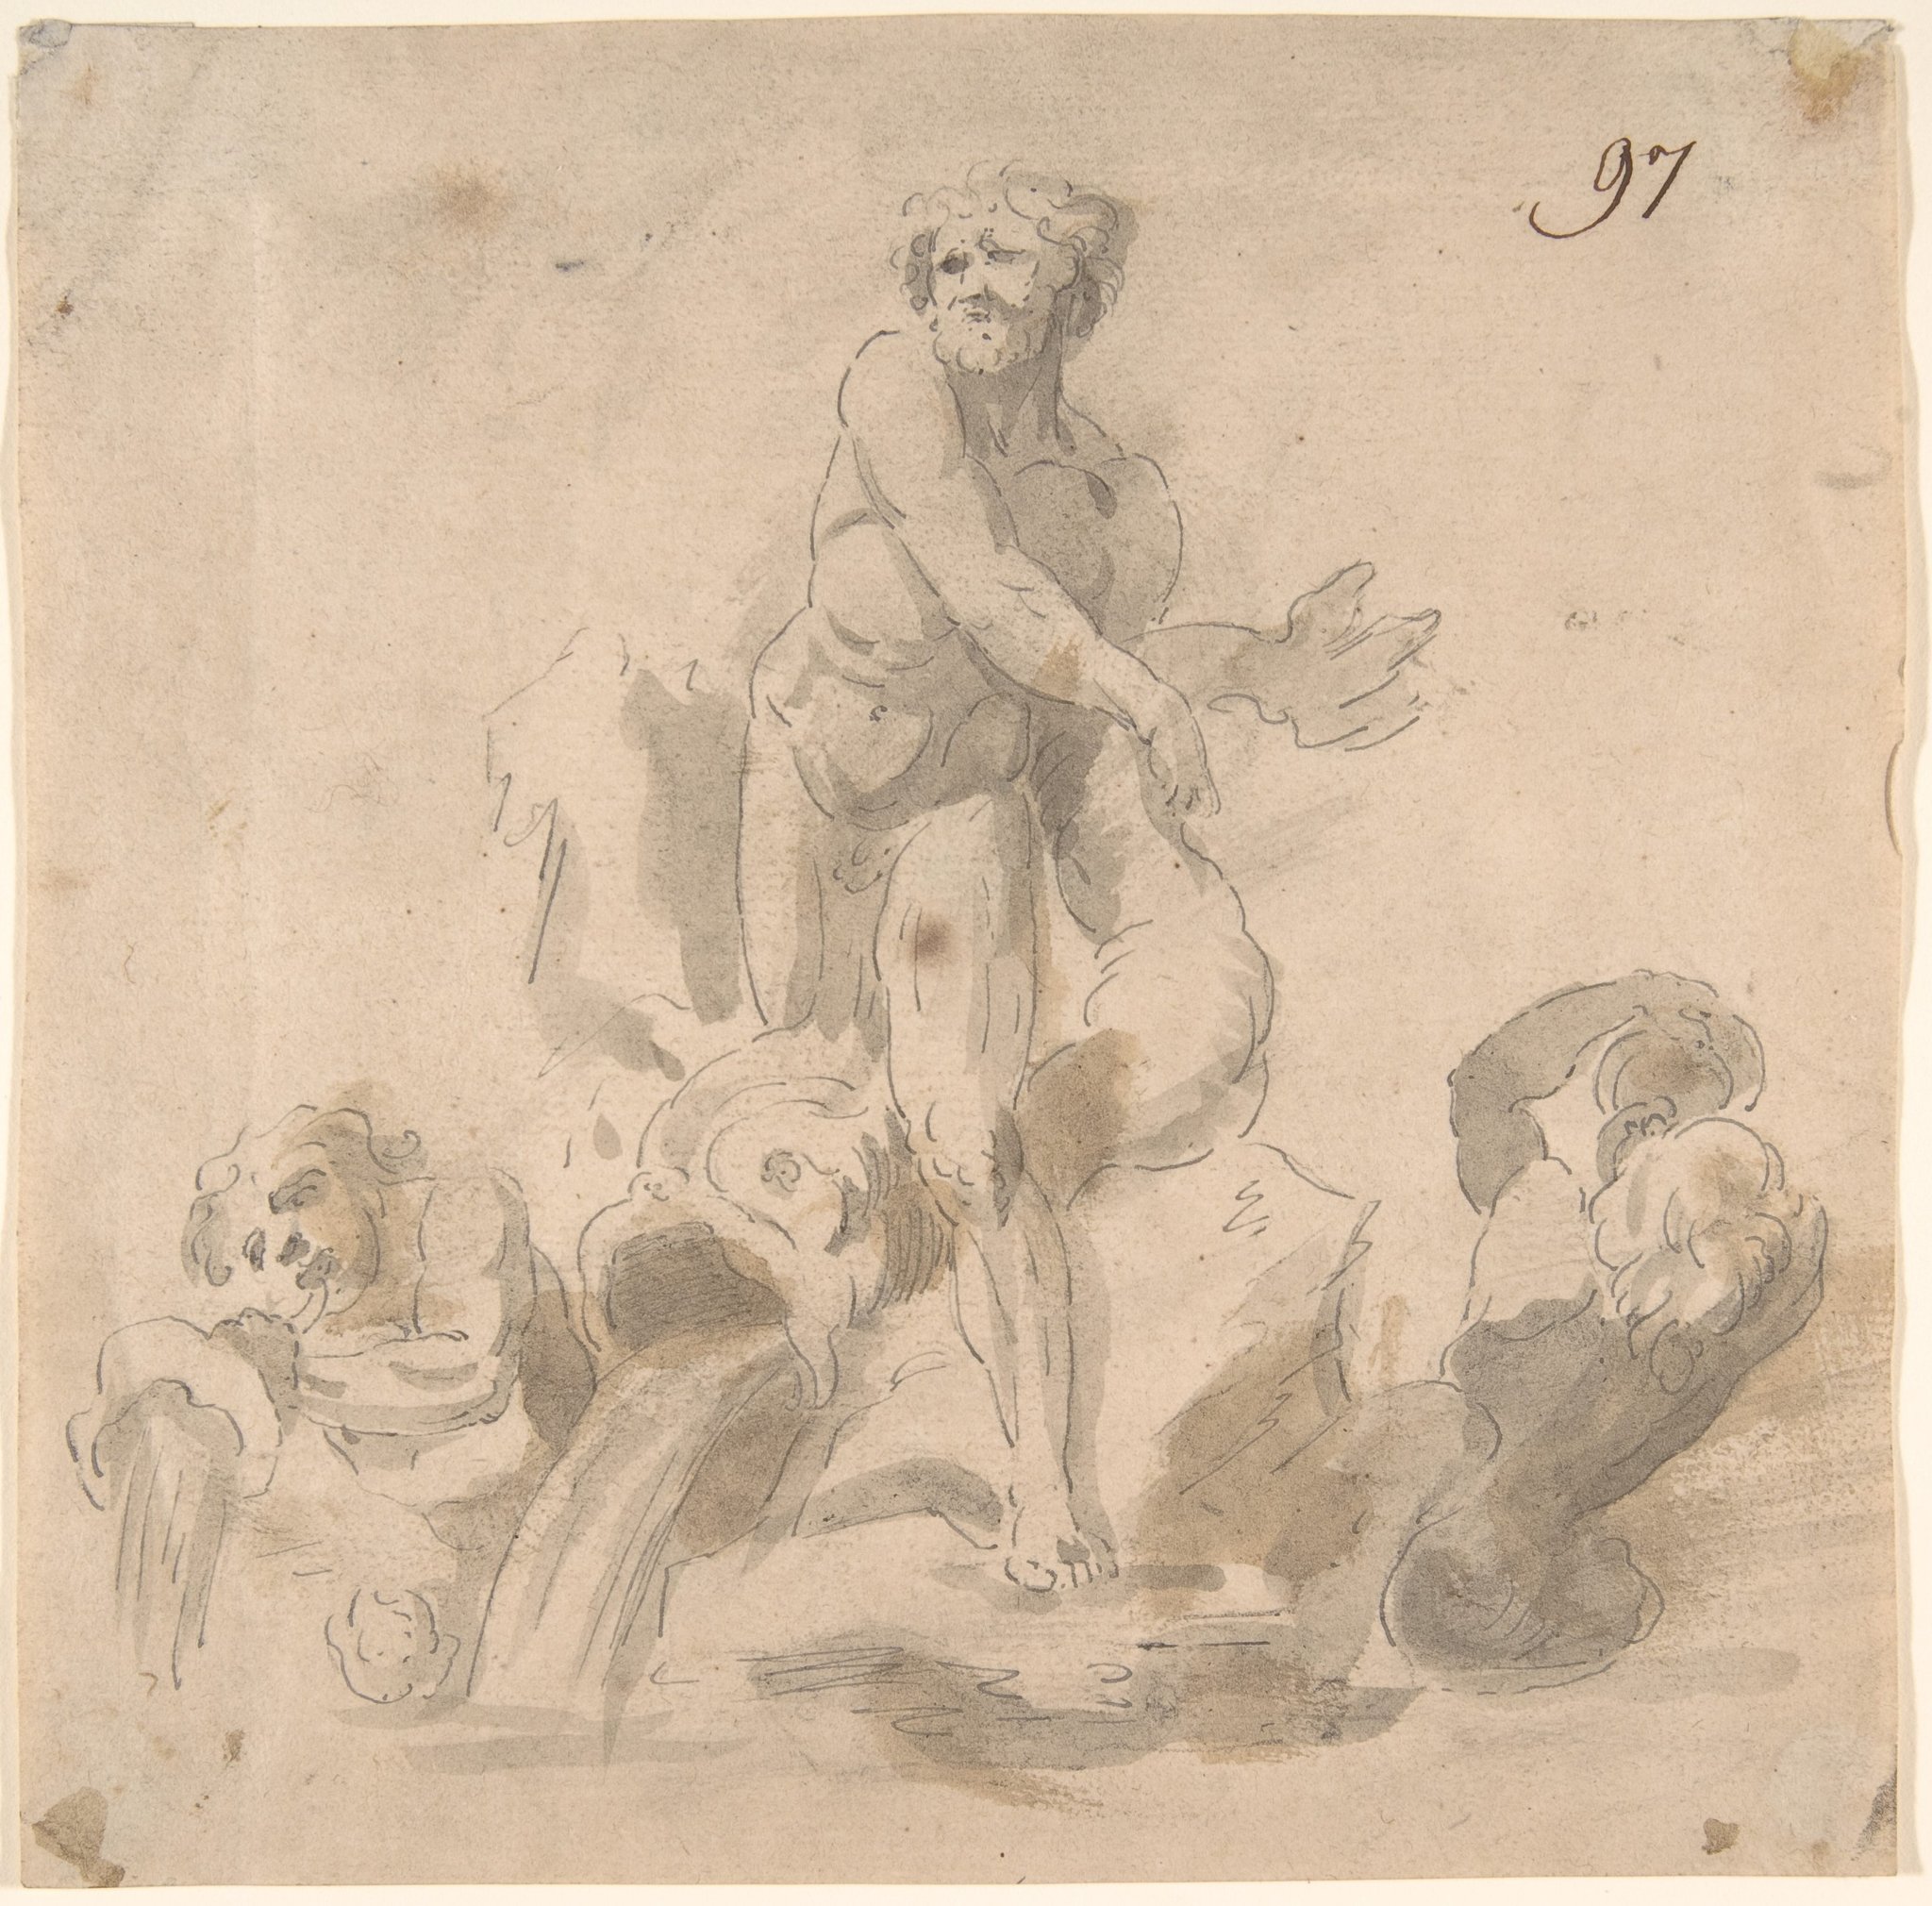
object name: drawing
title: Design for a Fountain with a River God, Dolphins and other Figures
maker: anonymous, italian, 17th century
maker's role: artist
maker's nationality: italian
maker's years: 1600-1700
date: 1601-1700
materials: ink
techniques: brush, pen, wash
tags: fountains,male nudes